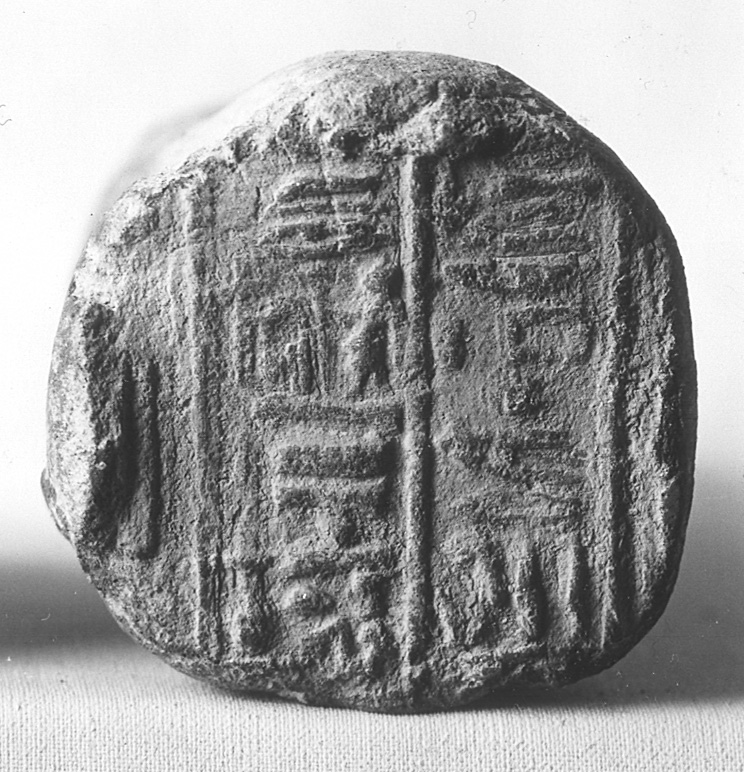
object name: cone, rectangular impression, neferhotep, scribe of amun, meryre, house mistress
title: Funerary Cone of Neferhotep and His Wife Meryre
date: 1550-1352 BCE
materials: pottery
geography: egypt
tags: hieroglyphs